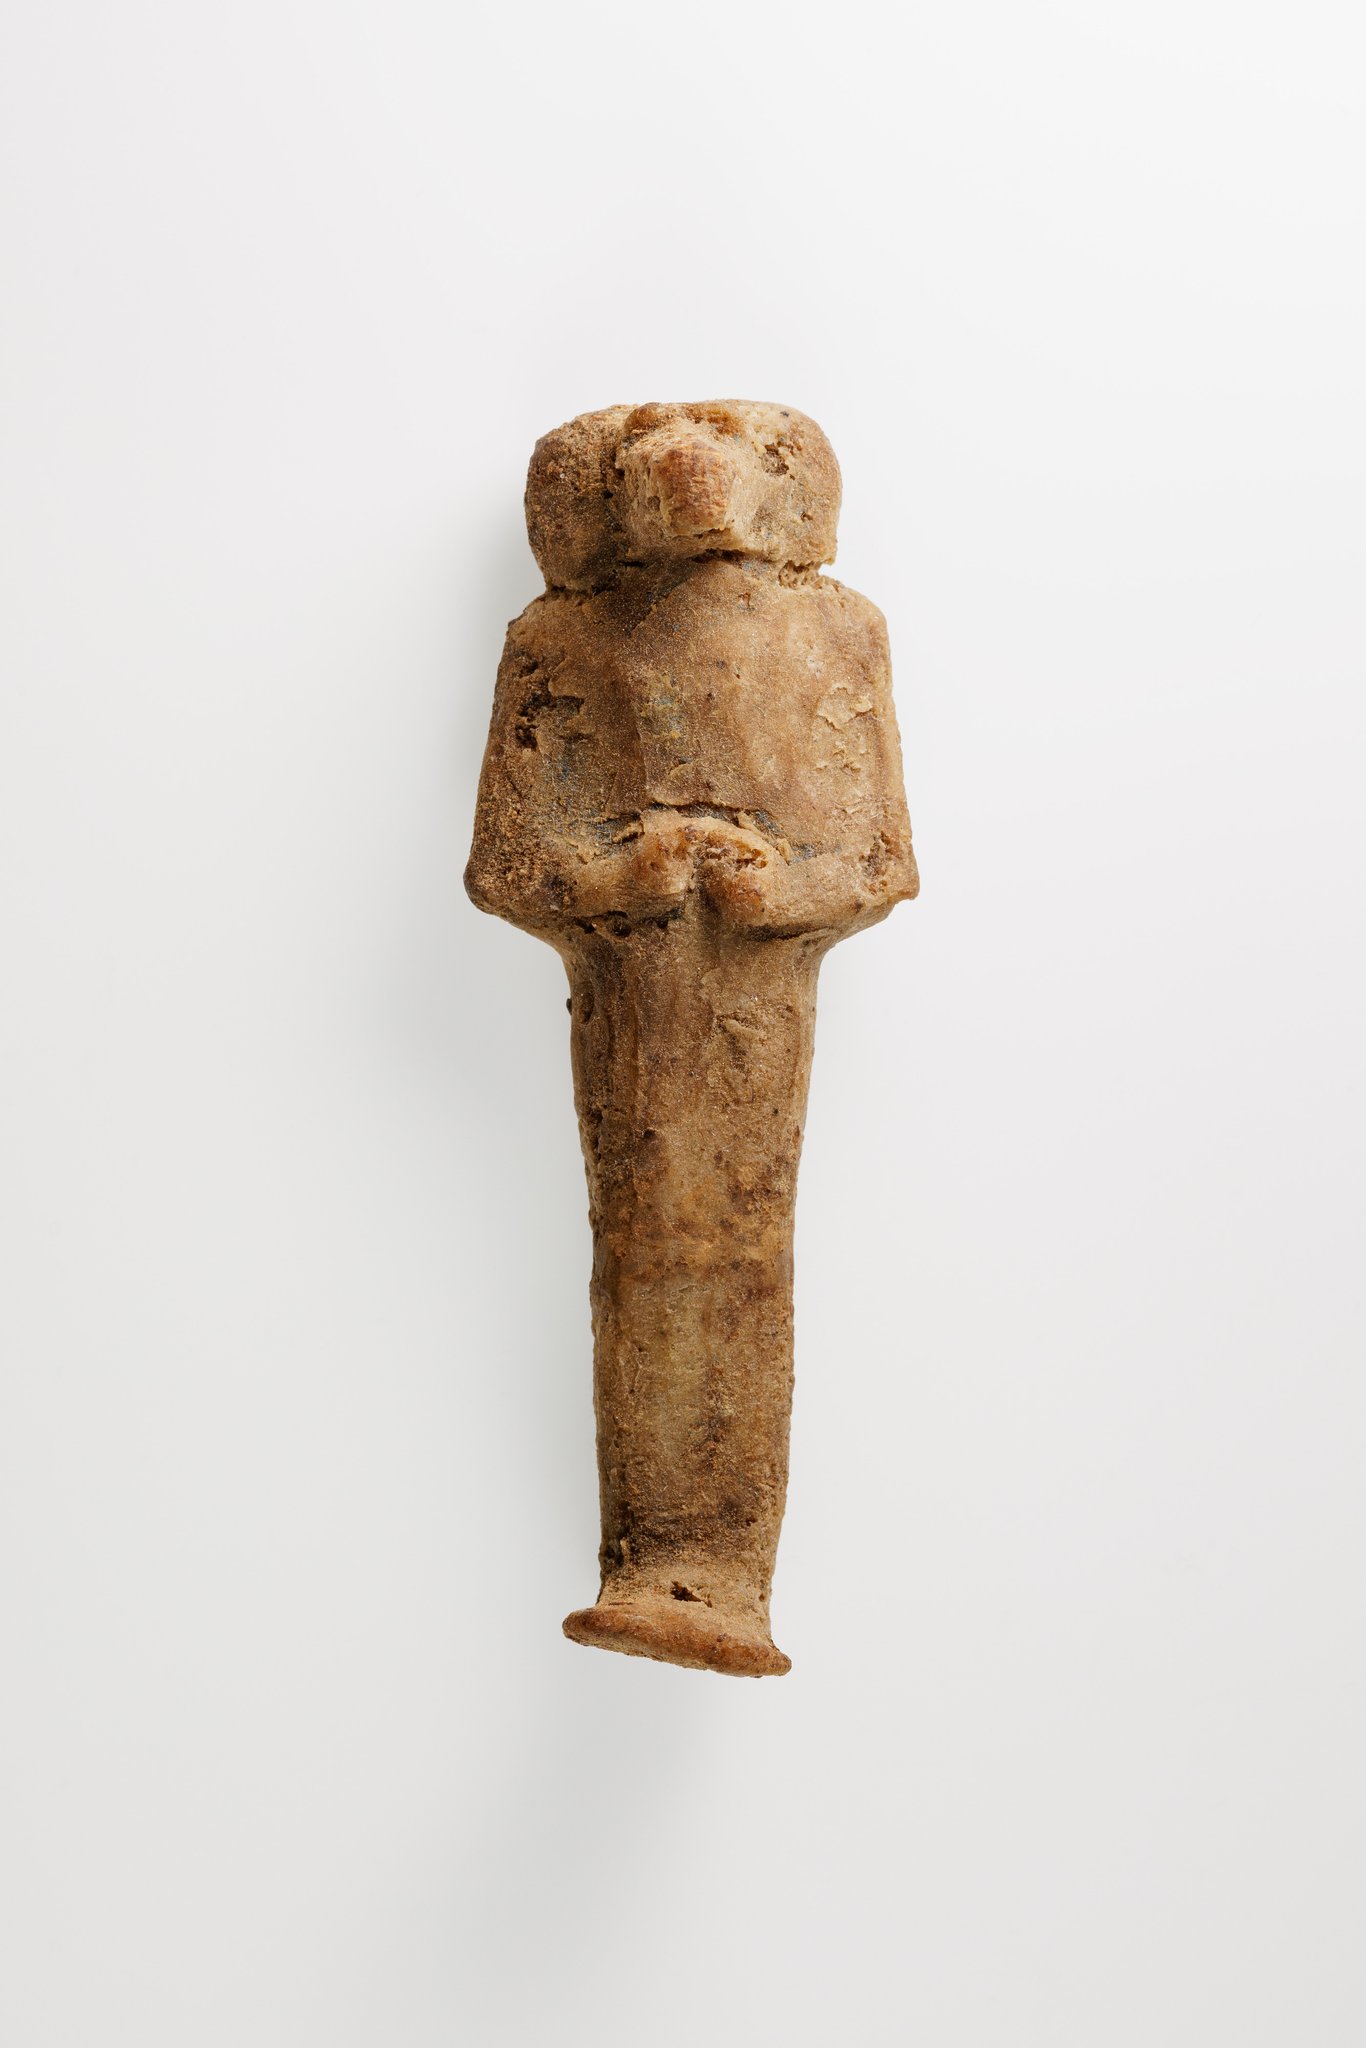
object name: four son of horus, hapy, baboon headed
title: Viscera figure with baboon head (Hapy)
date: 1000-945 BCE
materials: mud, wax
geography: egypt